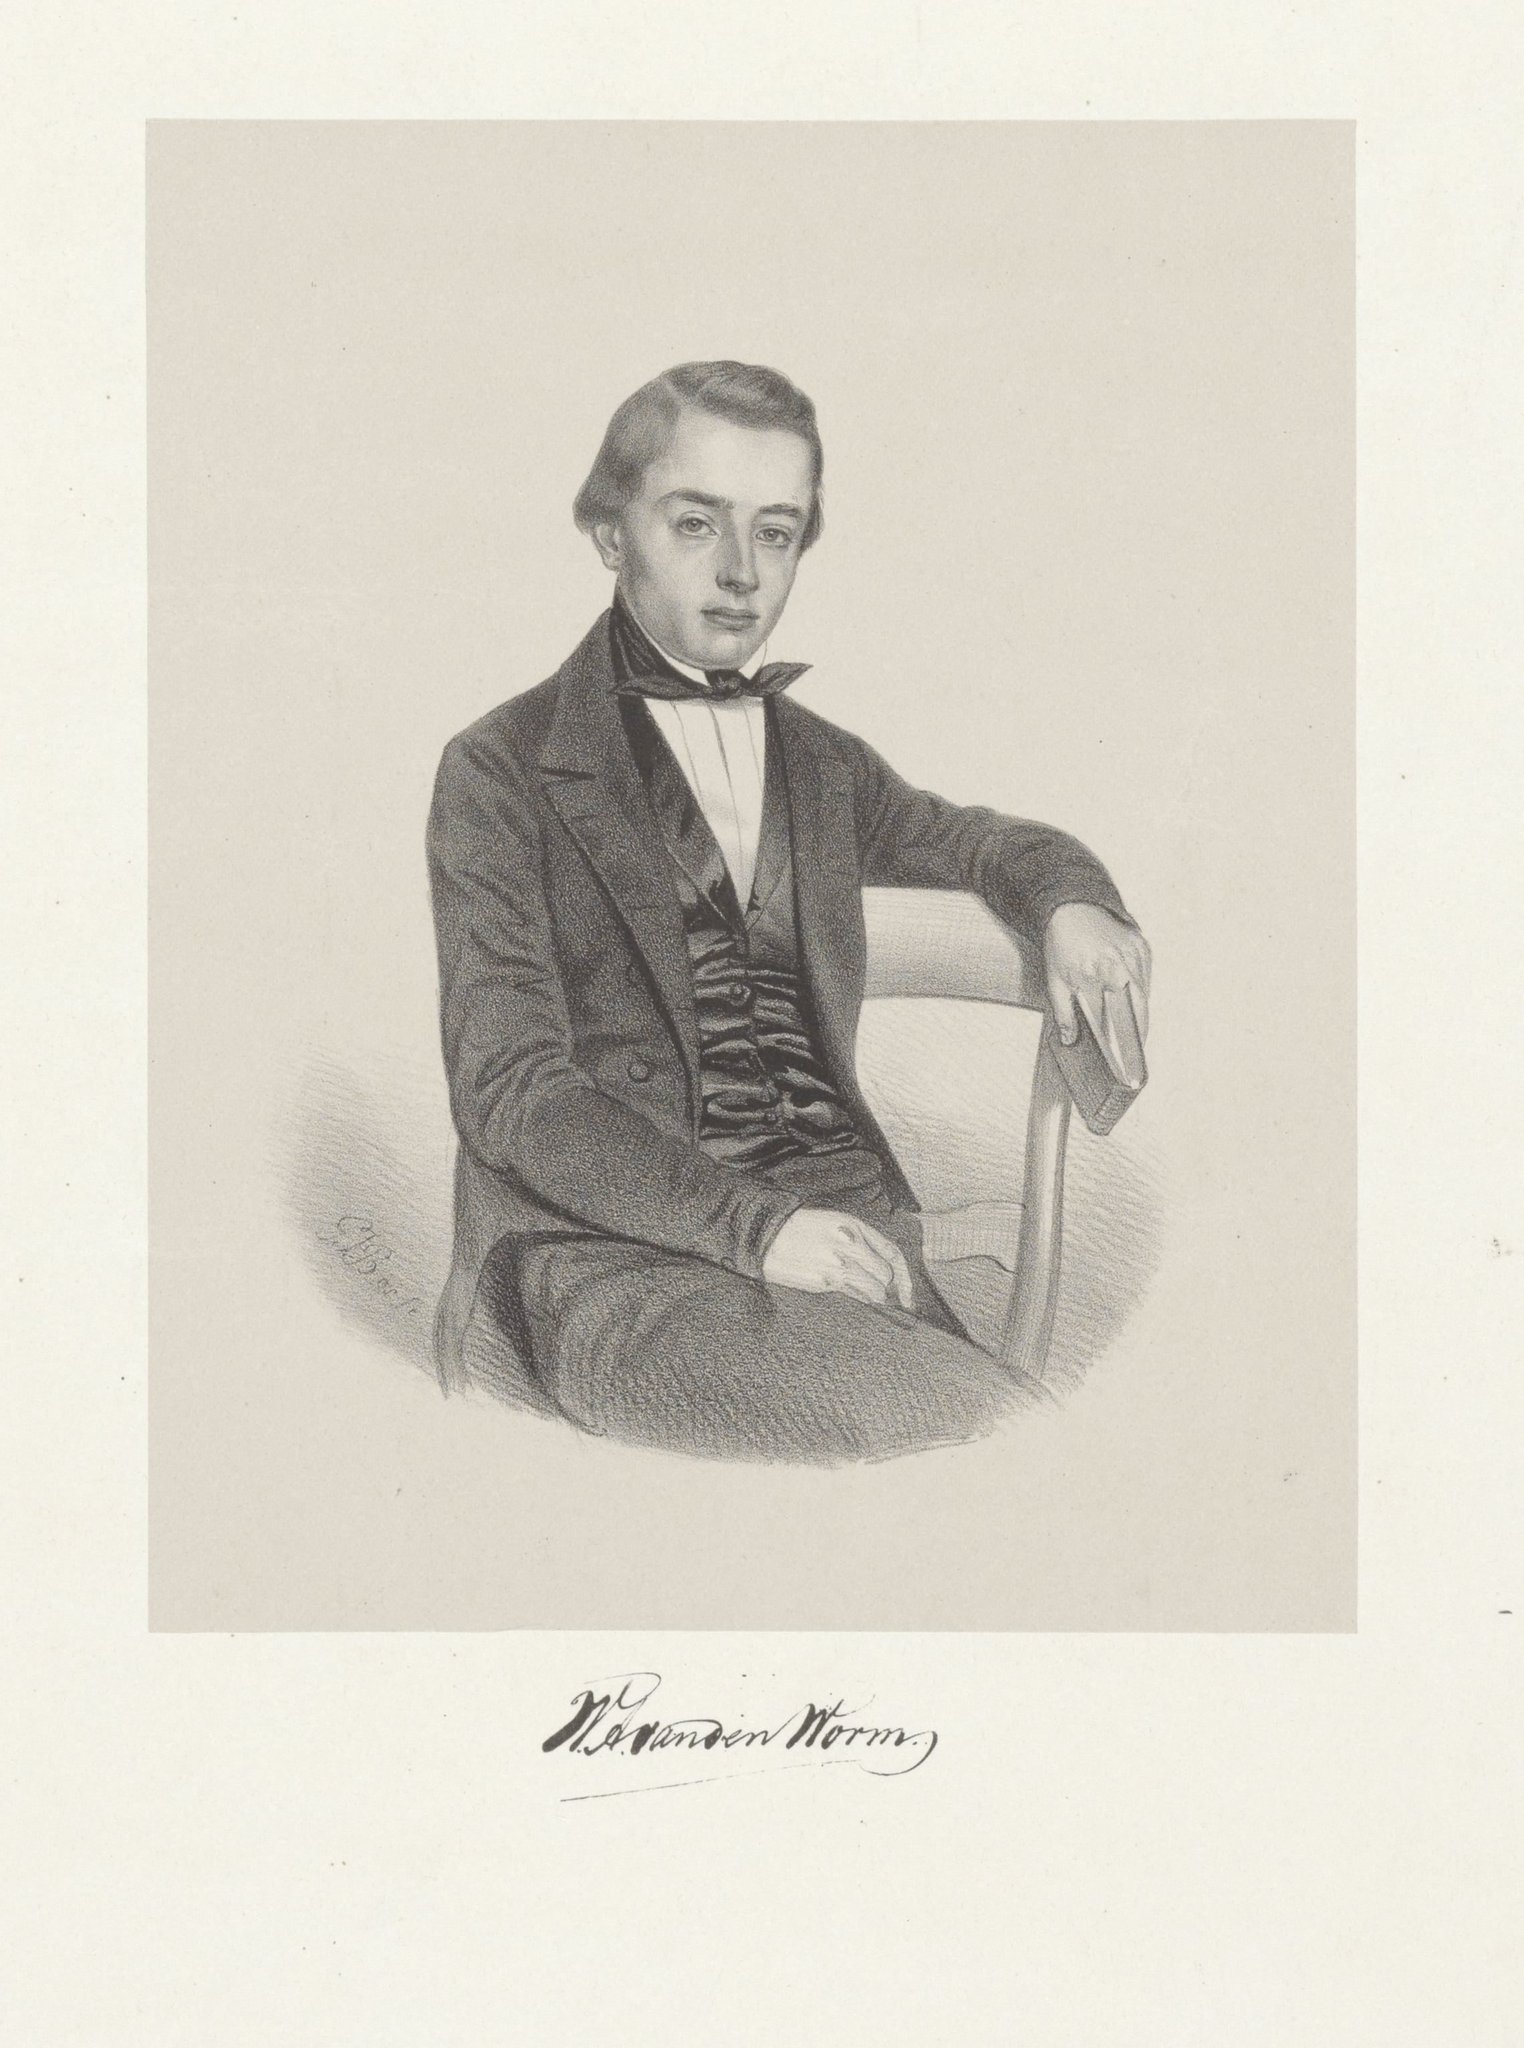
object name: print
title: Portret van W. A. van den Worm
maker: gerardus johannes bos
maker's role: painter, print maker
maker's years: 1825-1898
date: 1835-1898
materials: paper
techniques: lithograph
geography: netherlands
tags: sitting on an elevation (+ three-quarter view), historical persons, book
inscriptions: collector's mark: Lugt 2228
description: De geportretteerde zit op een stoel en leunt met zijn linkerarm op de rugleuning. In zijn linkerhand heeft hij een boek, zijn vingers tussen de bladzijden. Onder het portret zijn signatuur.